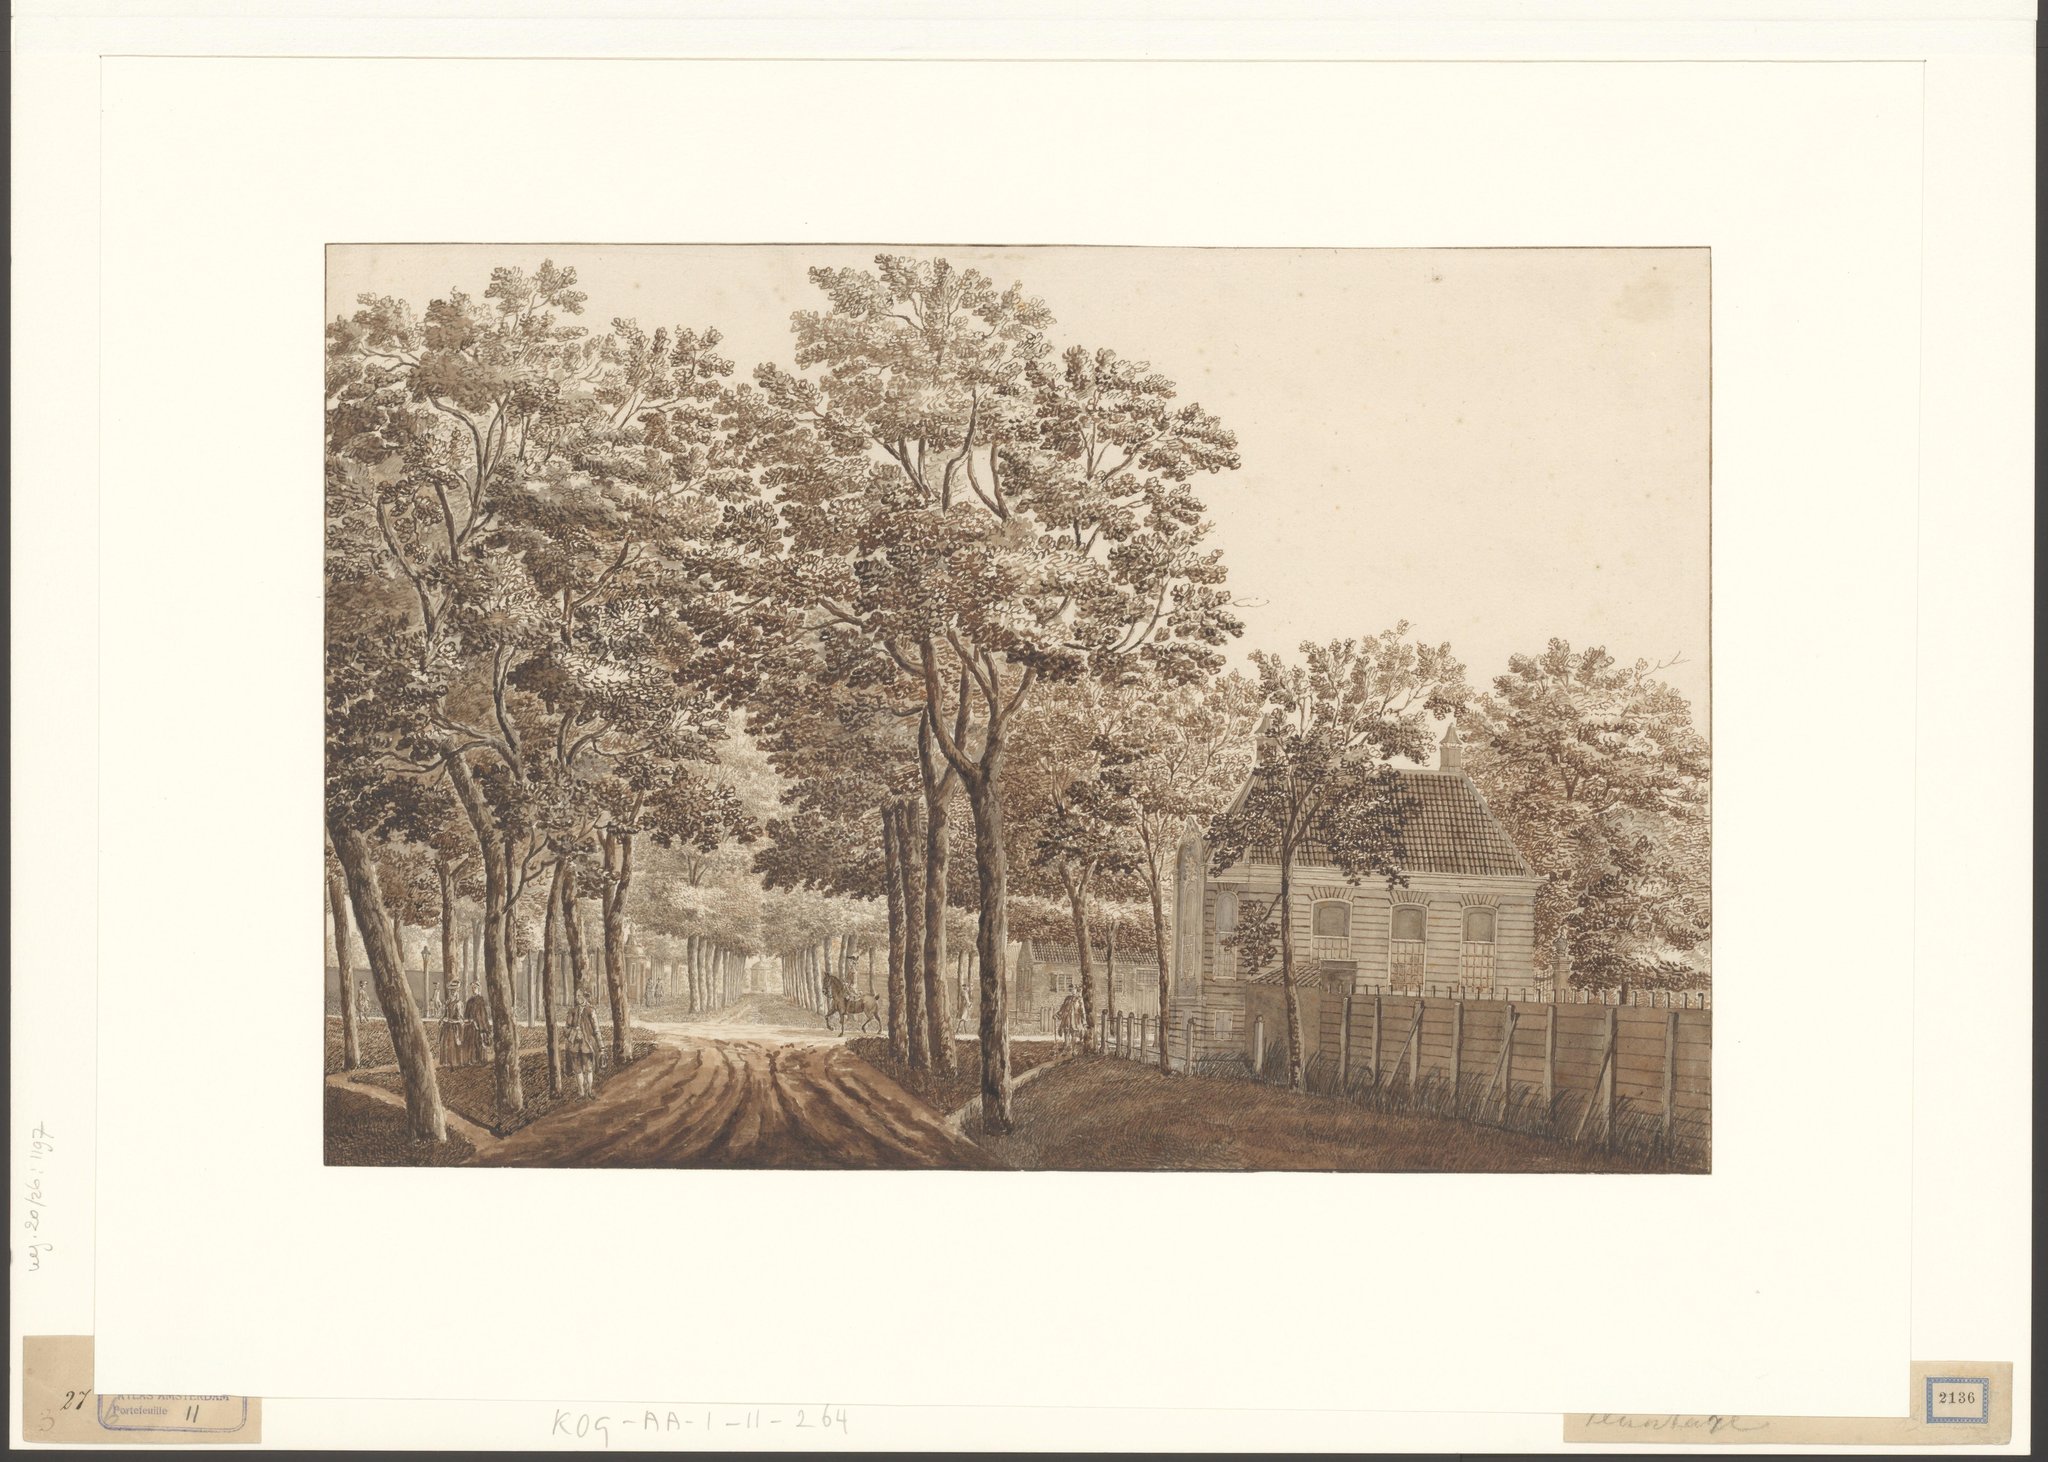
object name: drawing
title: Gezicht op de Plantage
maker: Anonymous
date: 1800-1899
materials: ink, paper, pencil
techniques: brush, pen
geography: amsterdam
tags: city-view in general; 'veduta', road, path, public gardens, park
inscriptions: collector's mark: ‘11- 264 / 3 / 2’ Lugt 1641b, inscription: ‘Port-11-264’, inscription: ‘Plantage 2136’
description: Onderwerpsrubriek binnen de Atlas Amsterdam: Paleisstraat, Palmgracht, Papenbrugsteeg, Passeerdersgracht, Peperstraat, Pieterspoort (St.), Pieterssteeg (St.), Plantage, Prinseneiland.